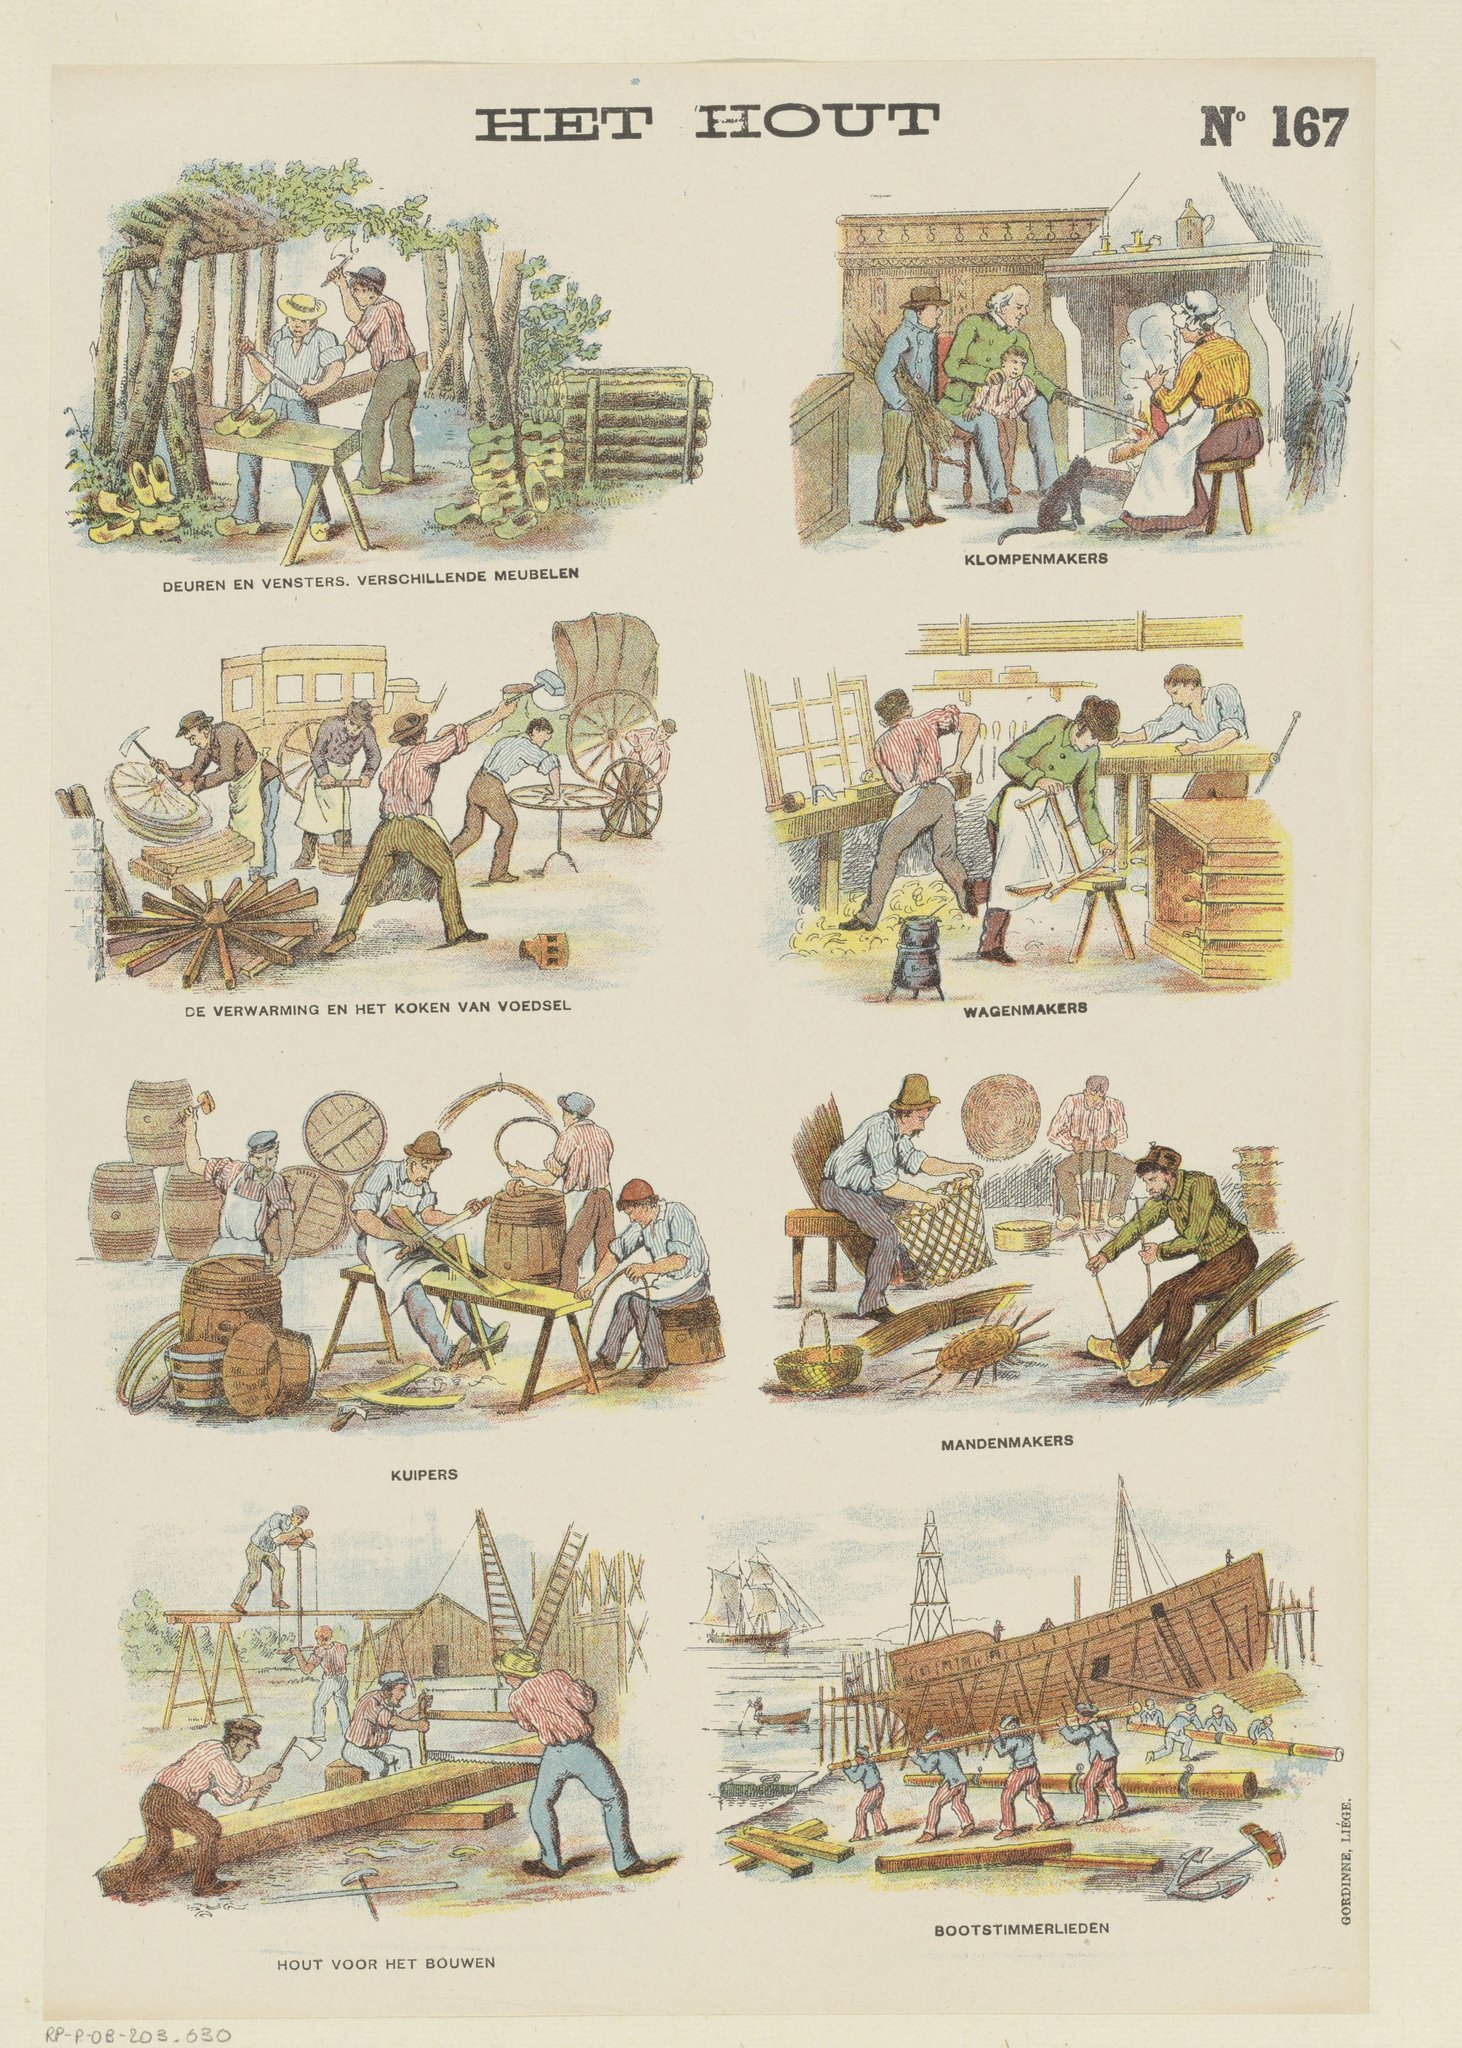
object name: popular print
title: Het hout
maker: Anonymous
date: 1894-1959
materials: paper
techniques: lithograph, letterpress printing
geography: liège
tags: turner in wood, industries ~ wood, handicrafts ~ wood, timber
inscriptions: collector's mark: Lugt 2760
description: Blad met 8 voorstellingen over het gebruik en de bewerking van hout. Onder andere voorstellingen van klompenmakers, wagenmakers en kuipers die gebruik maken van hout. Onder elke afbeelding een onderschrift. Genummerd rechtsboven: No 167.